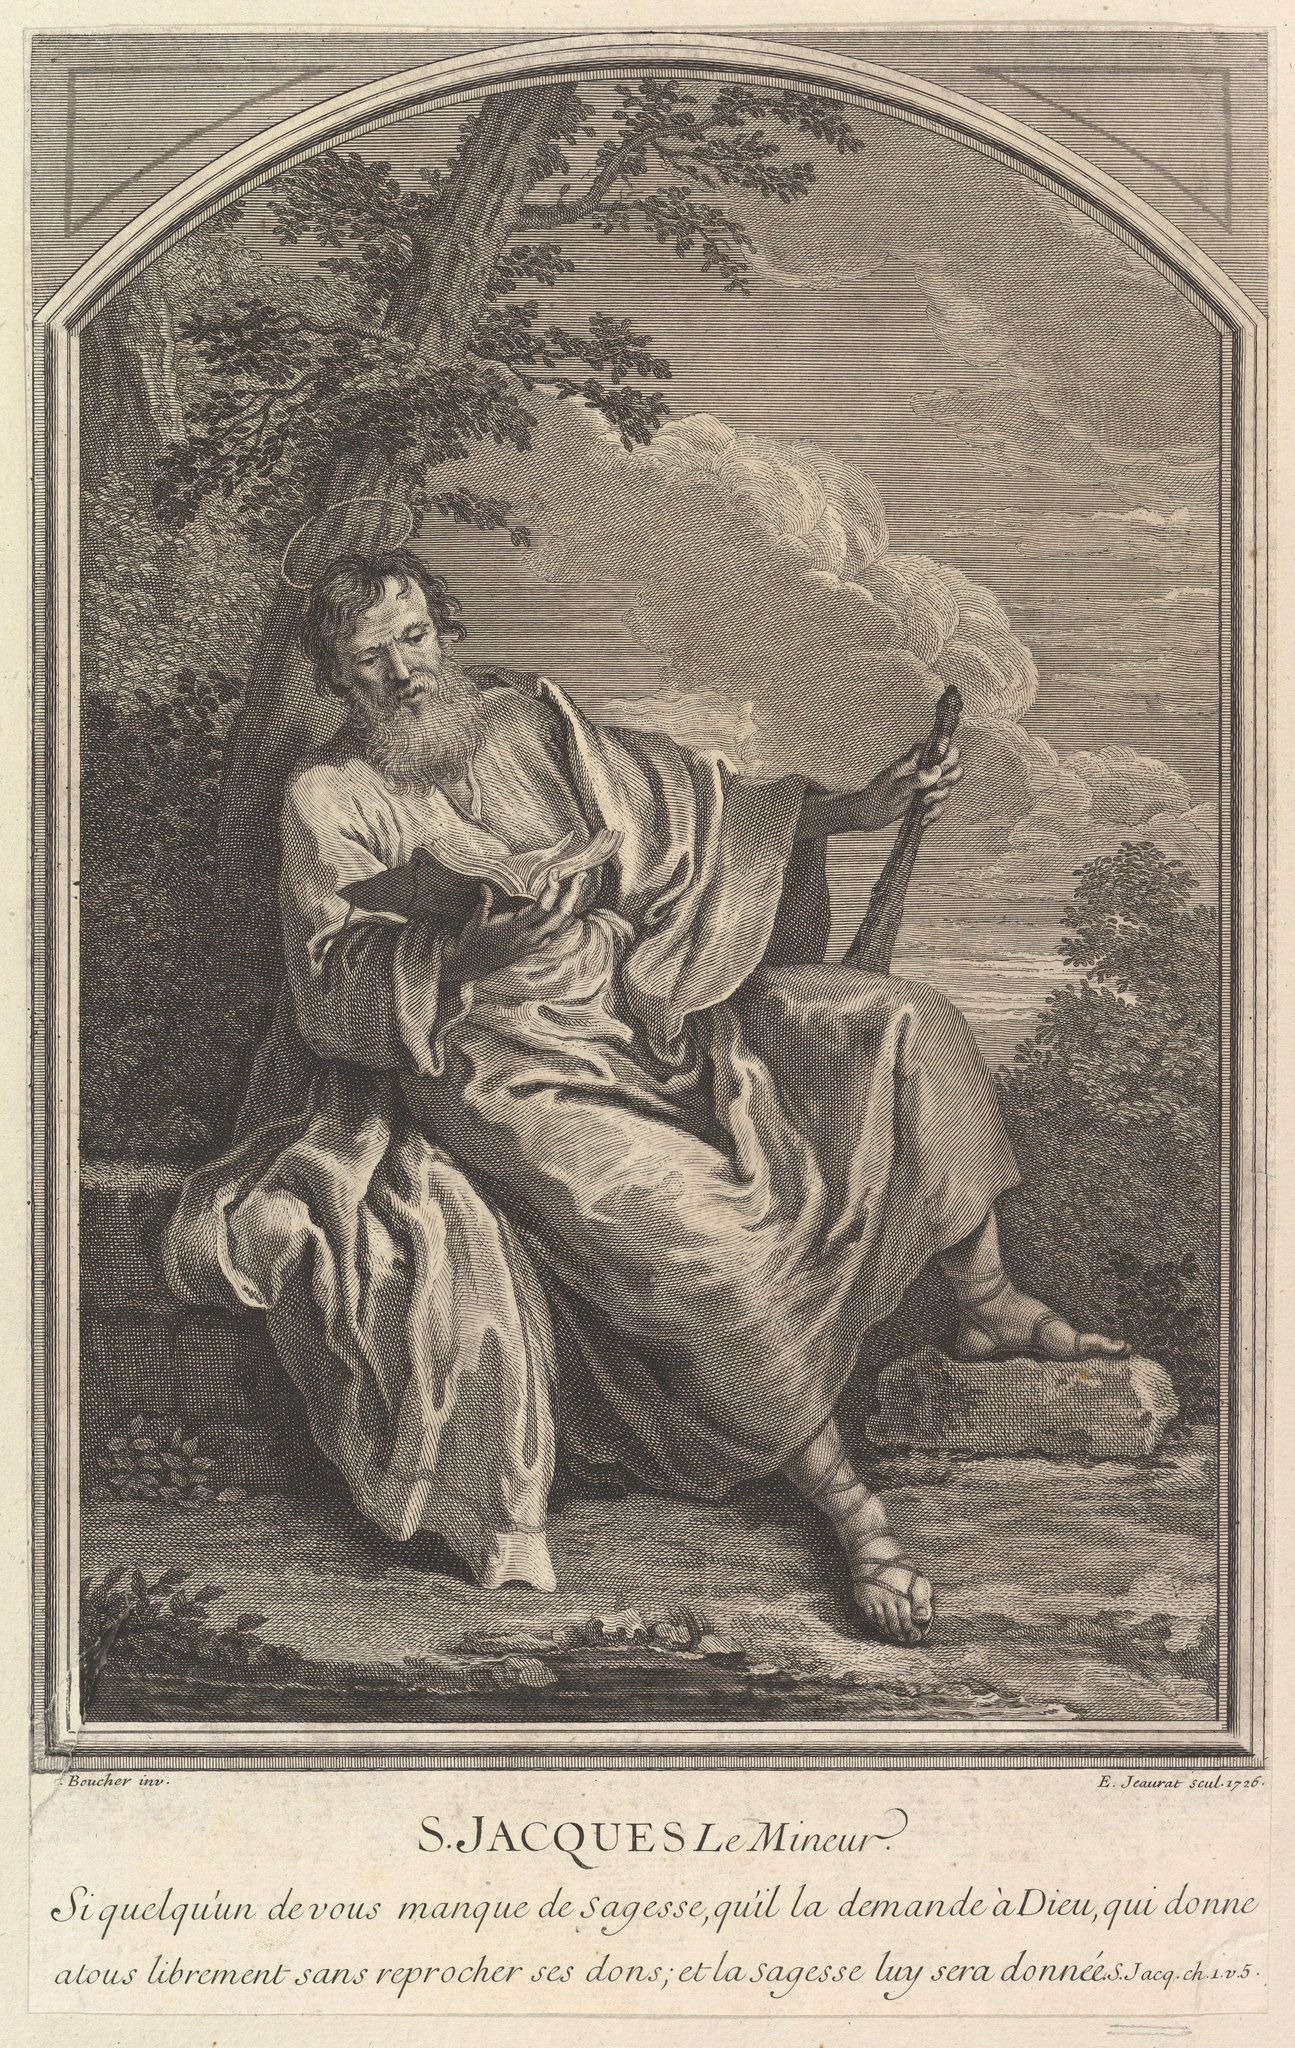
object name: print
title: Saint Jacques Le Mineur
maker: edmé jeaurat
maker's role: artist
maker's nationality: french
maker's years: 1688-1738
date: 1726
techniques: engraving, etching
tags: men,reading,saints